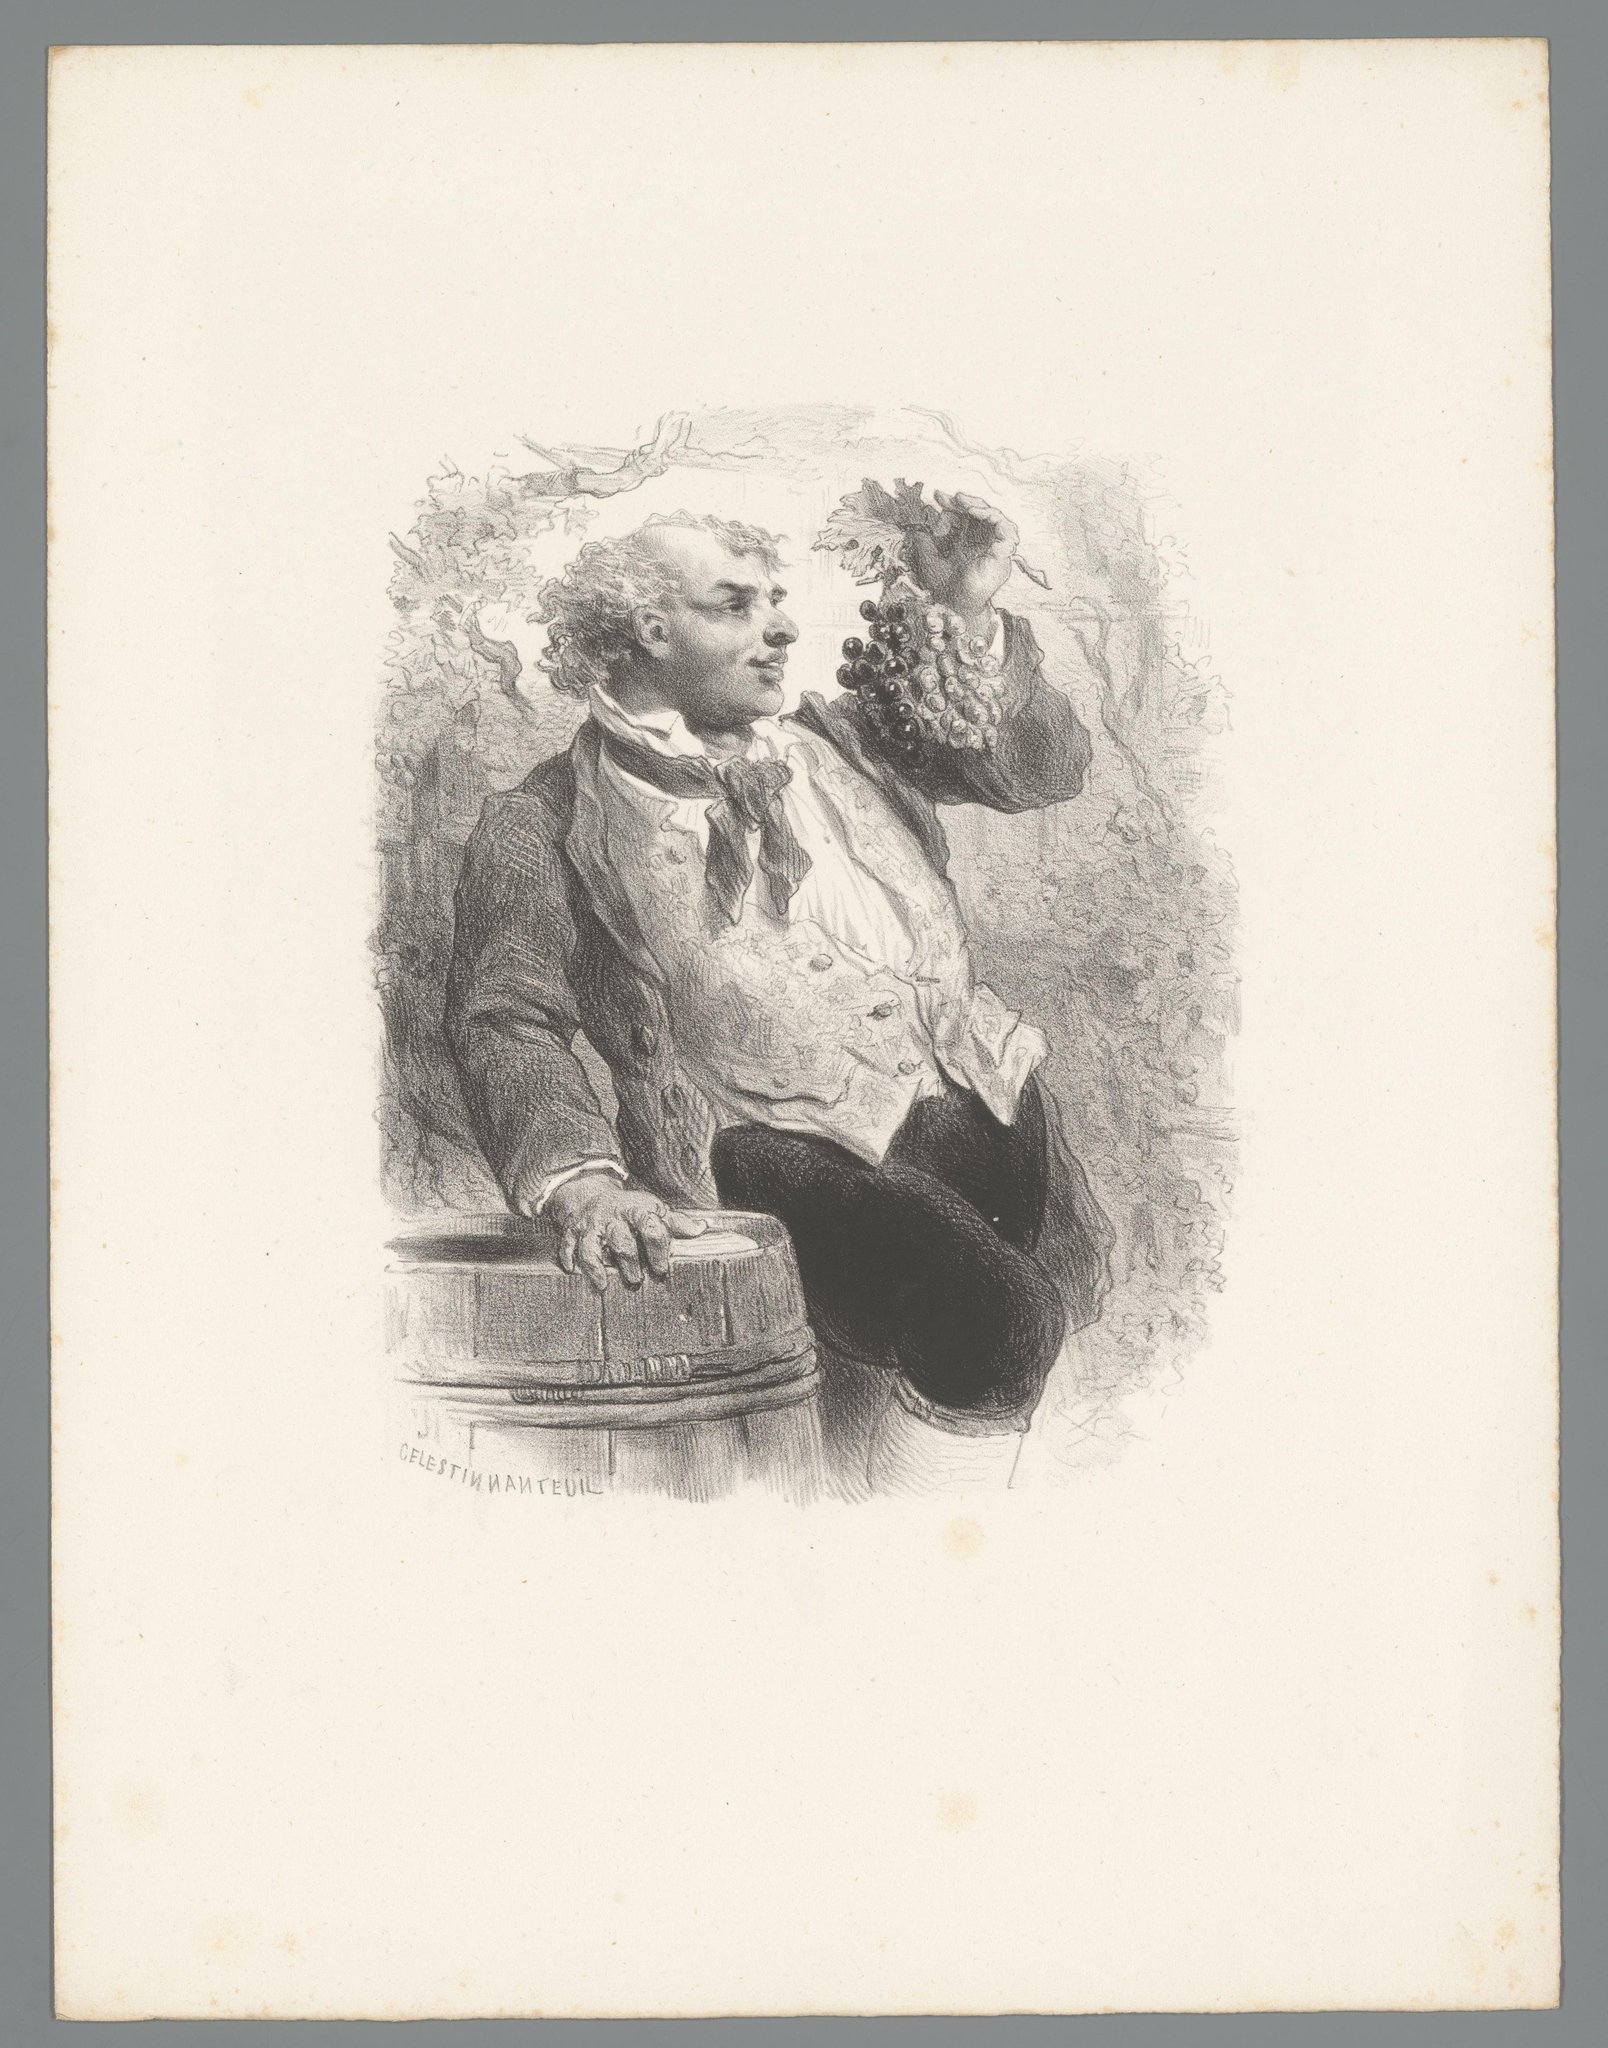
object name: print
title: Man leunend op een wijnvat met een tros druiven in zijn hand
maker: célestin françois nanteuil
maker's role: print maker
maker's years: 1813-1873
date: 1823-1873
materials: paper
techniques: lithograph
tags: wooden container: barrel, cask, bucket, adult man, wine ~ alcoholic drinks, bunch of grapes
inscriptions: collector's mark: Lugt 964